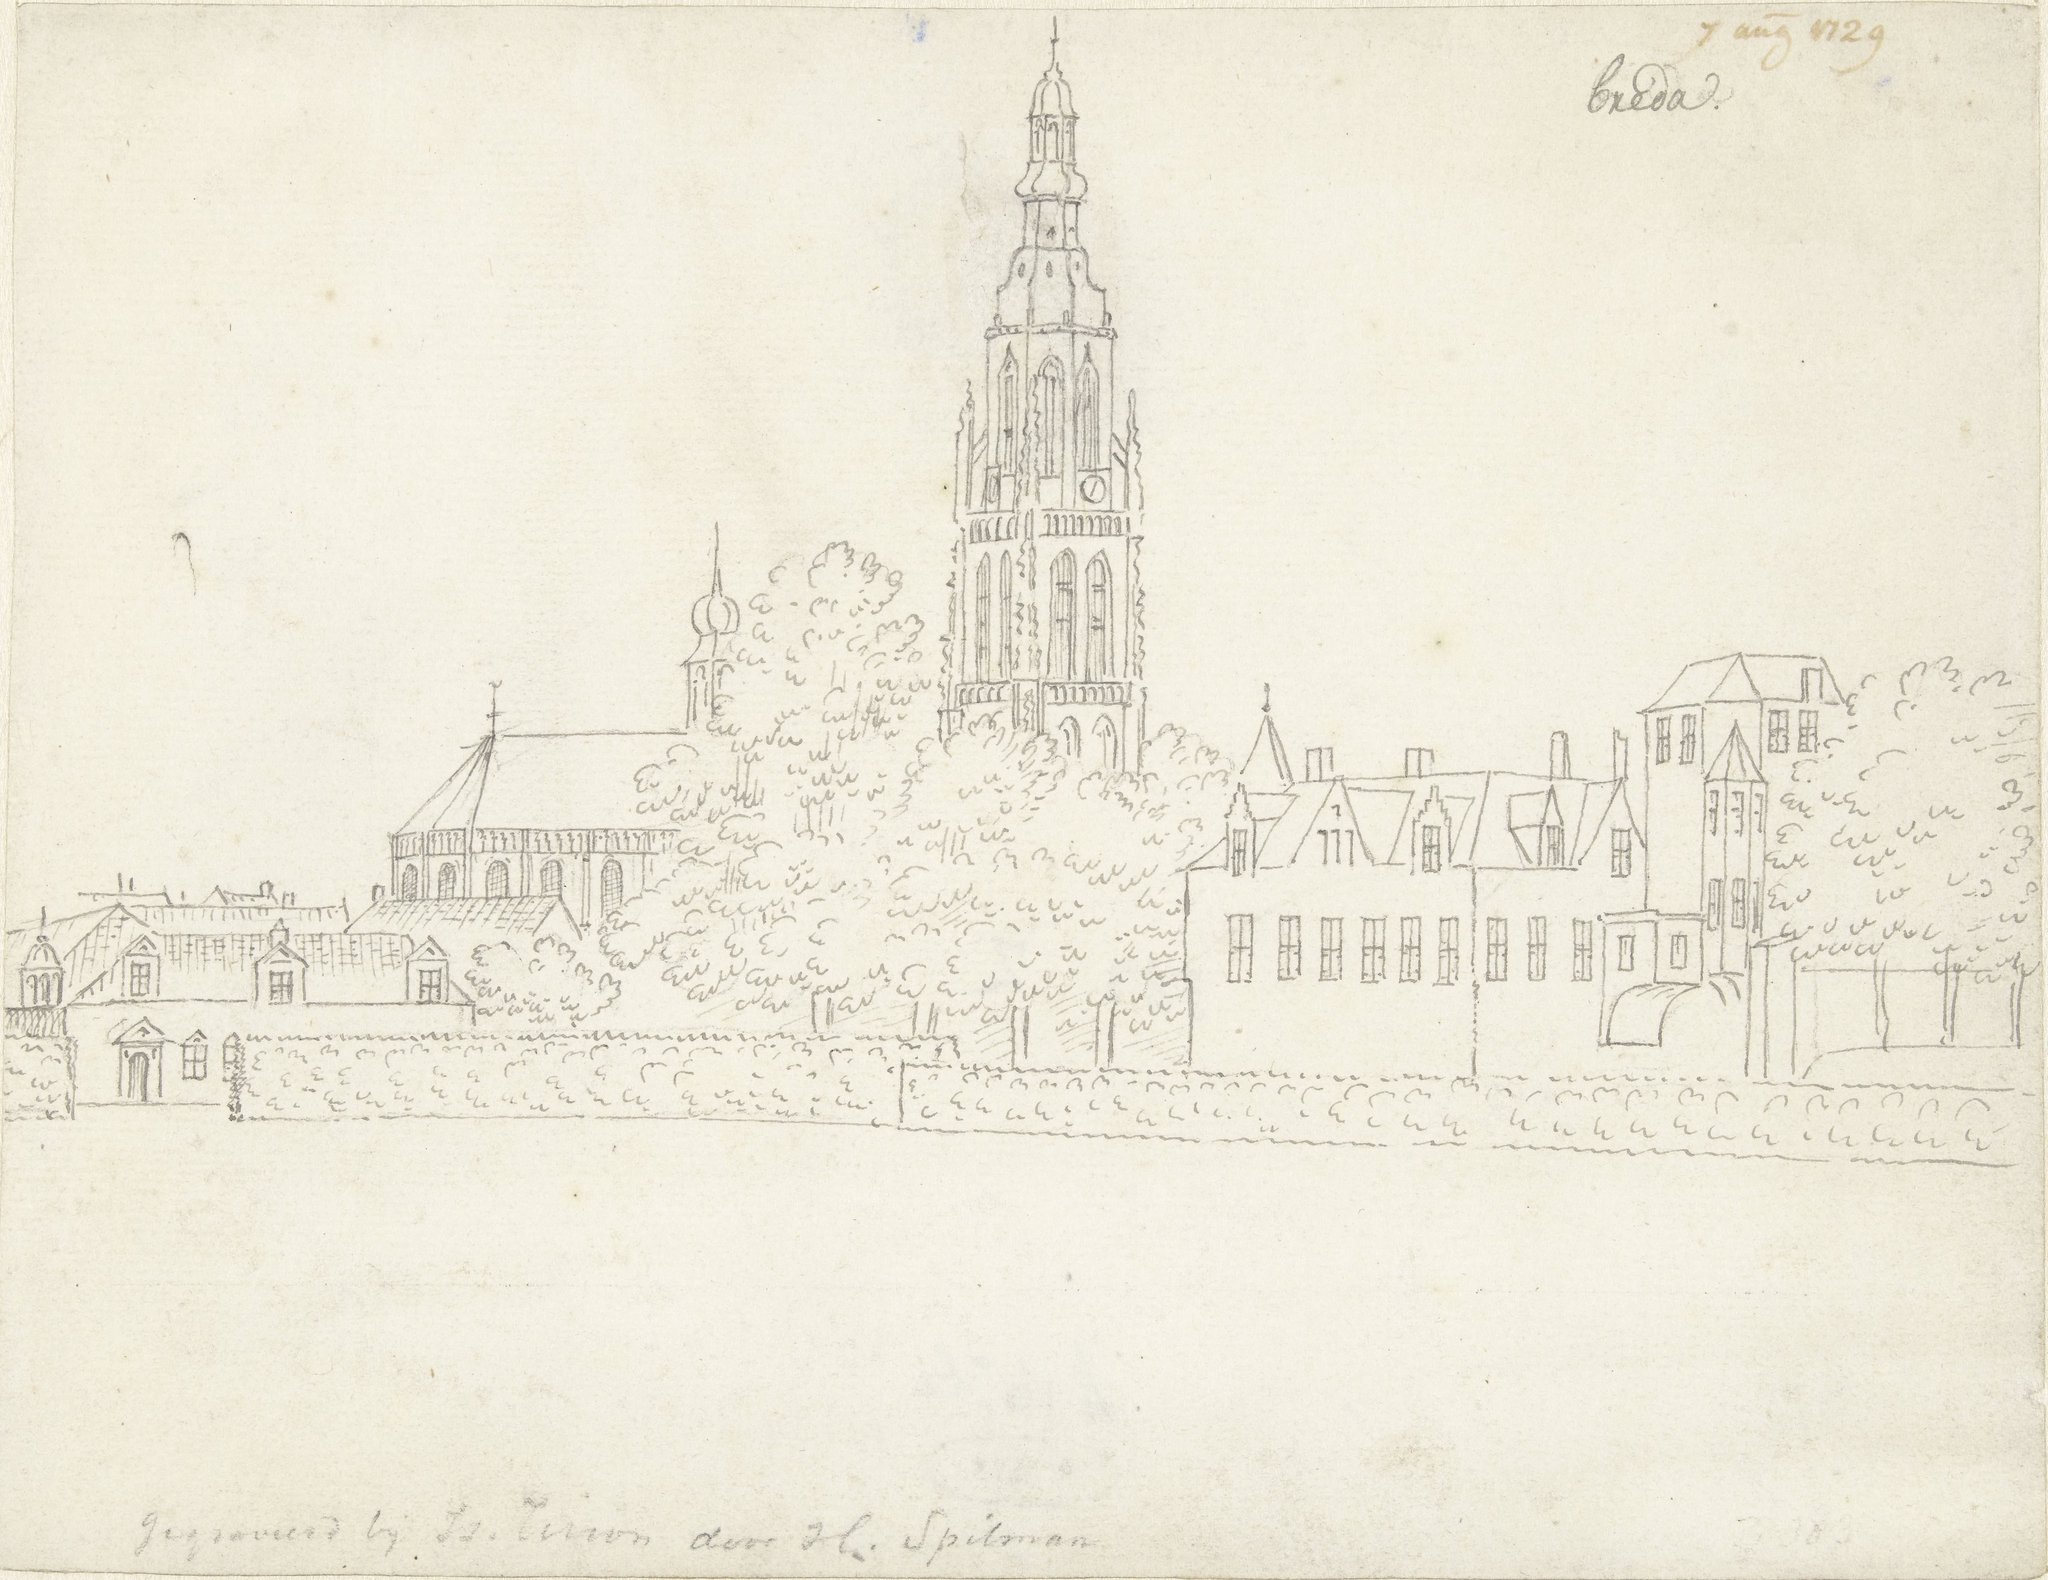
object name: drawing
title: Gezicht op Breda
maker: cornelis pronk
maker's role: draughtsman, painter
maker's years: 1691-1759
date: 1729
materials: ink, paper, pencil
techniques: pen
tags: church (exterior), prospect of city, town panorama, silhouette of city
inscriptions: inscription: ‘breda / 7 aug 1729’, inscription: ‘gegraveerd by Is. Tirion door H. Spilman’